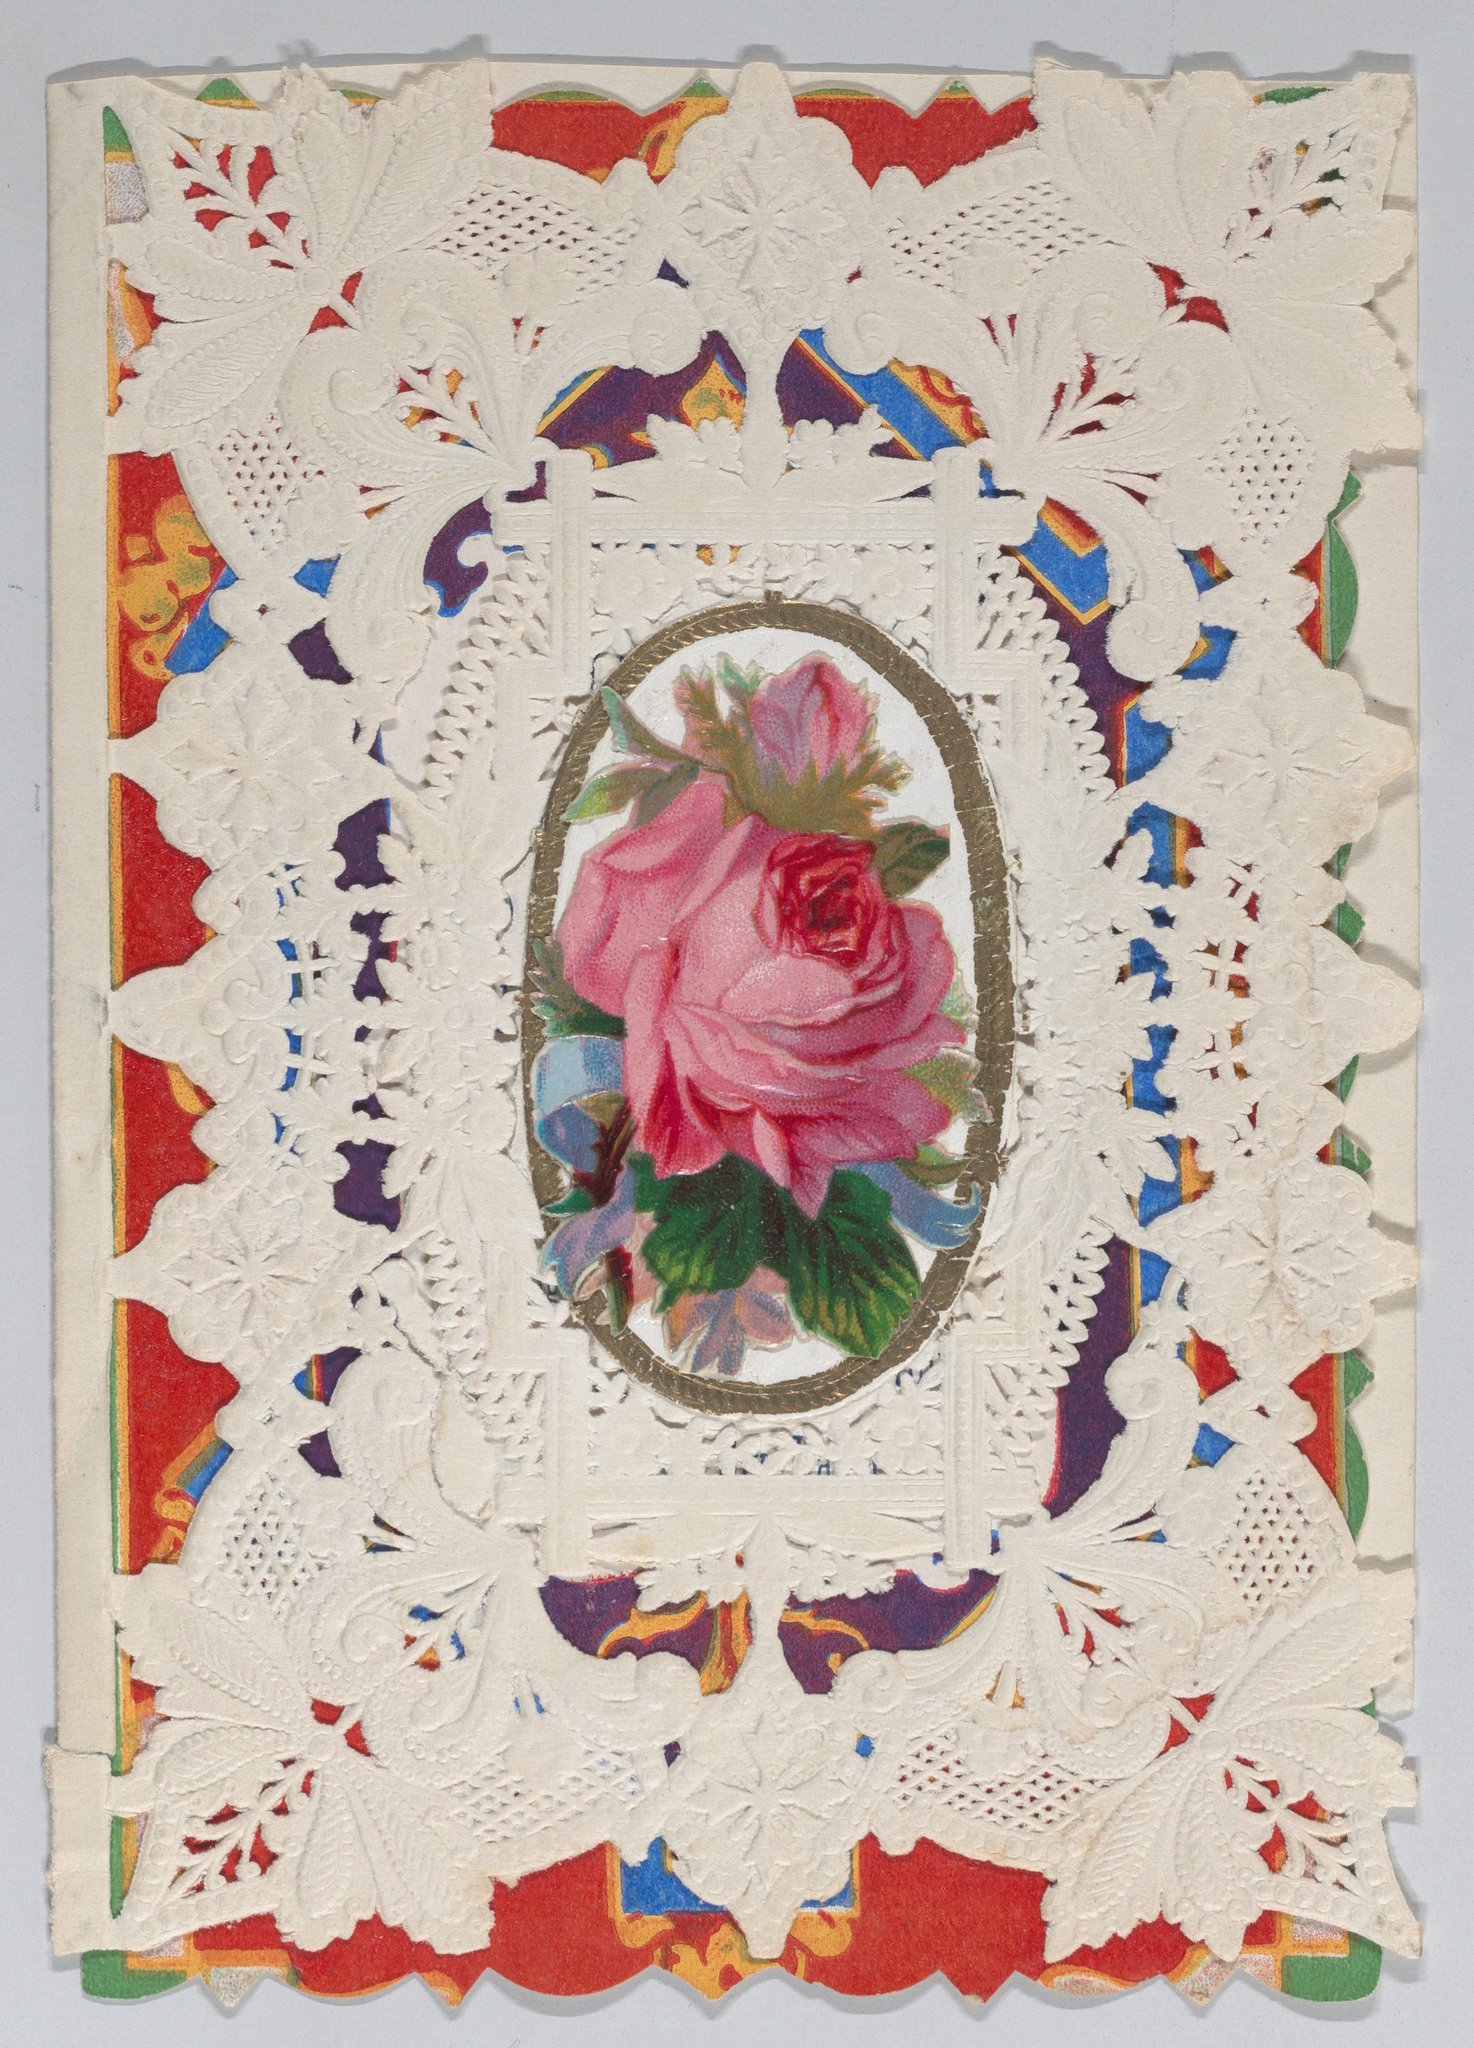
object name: valentine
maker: Anonymous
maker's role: artist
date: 1880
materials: paper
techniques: chromolithography, embossing